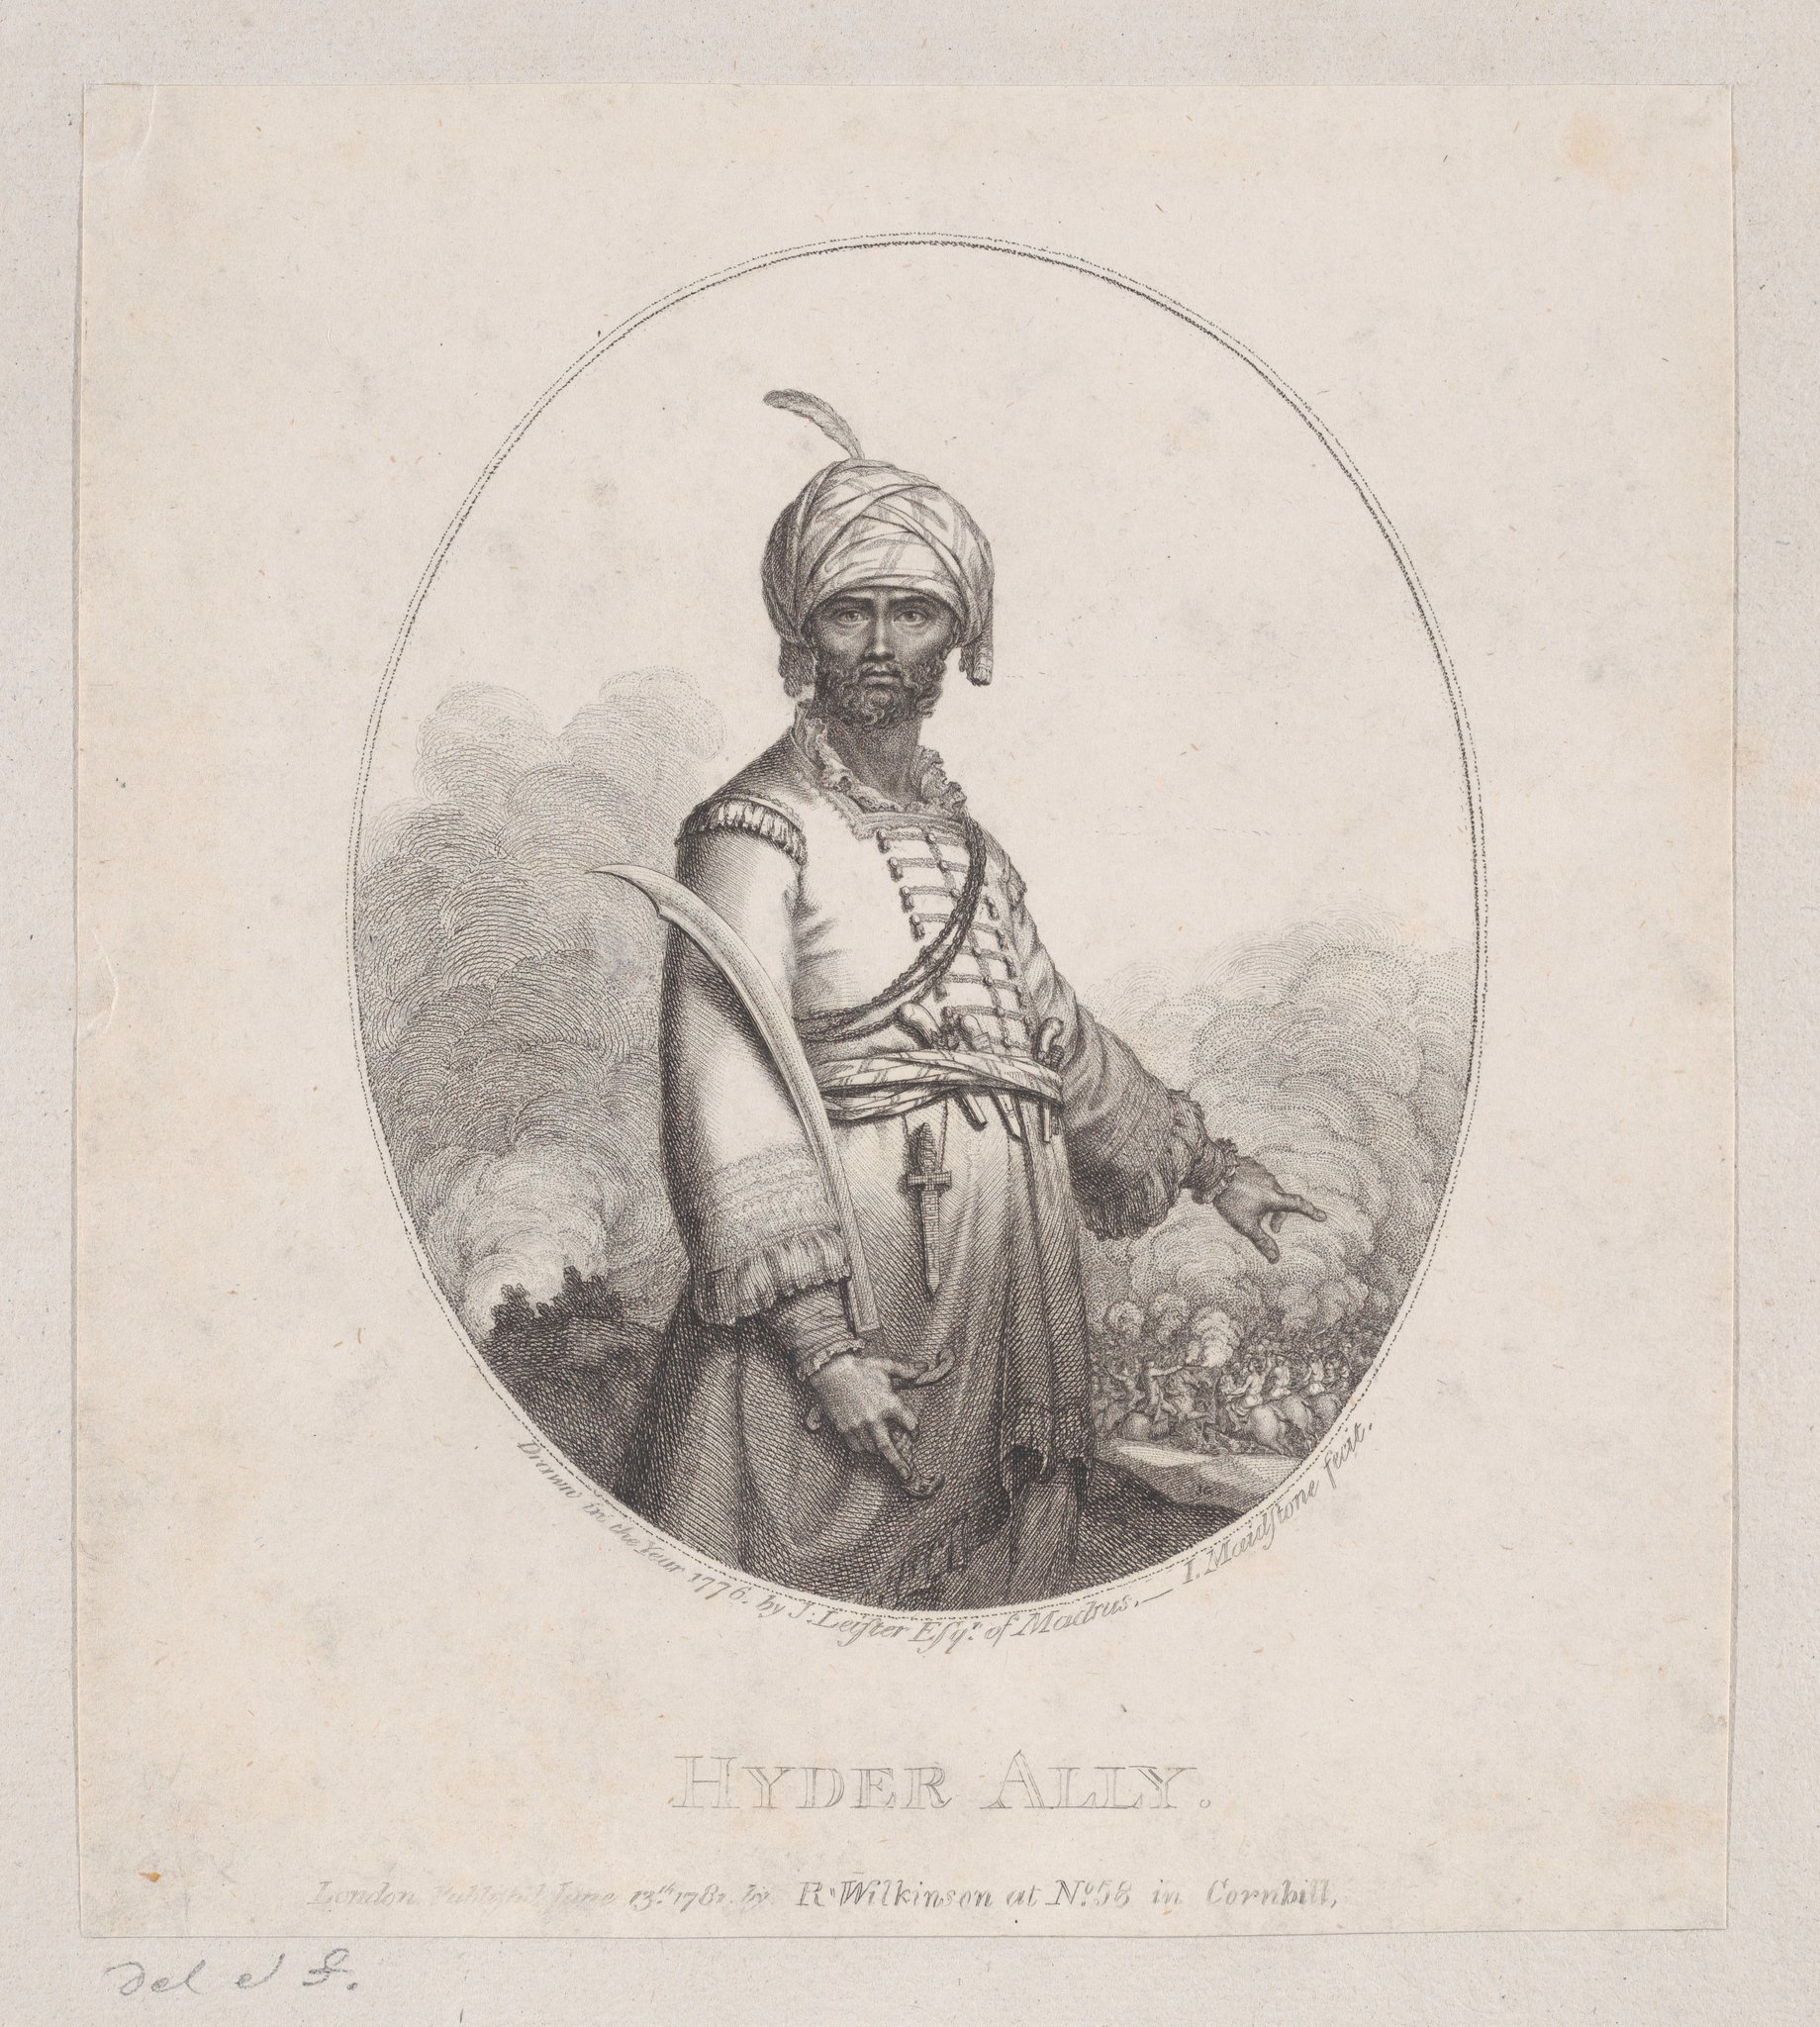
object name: print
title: Hyder Ally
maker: james gillray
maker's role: artist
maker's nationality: british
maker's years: 1756-1815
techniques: engraving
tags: swords,men